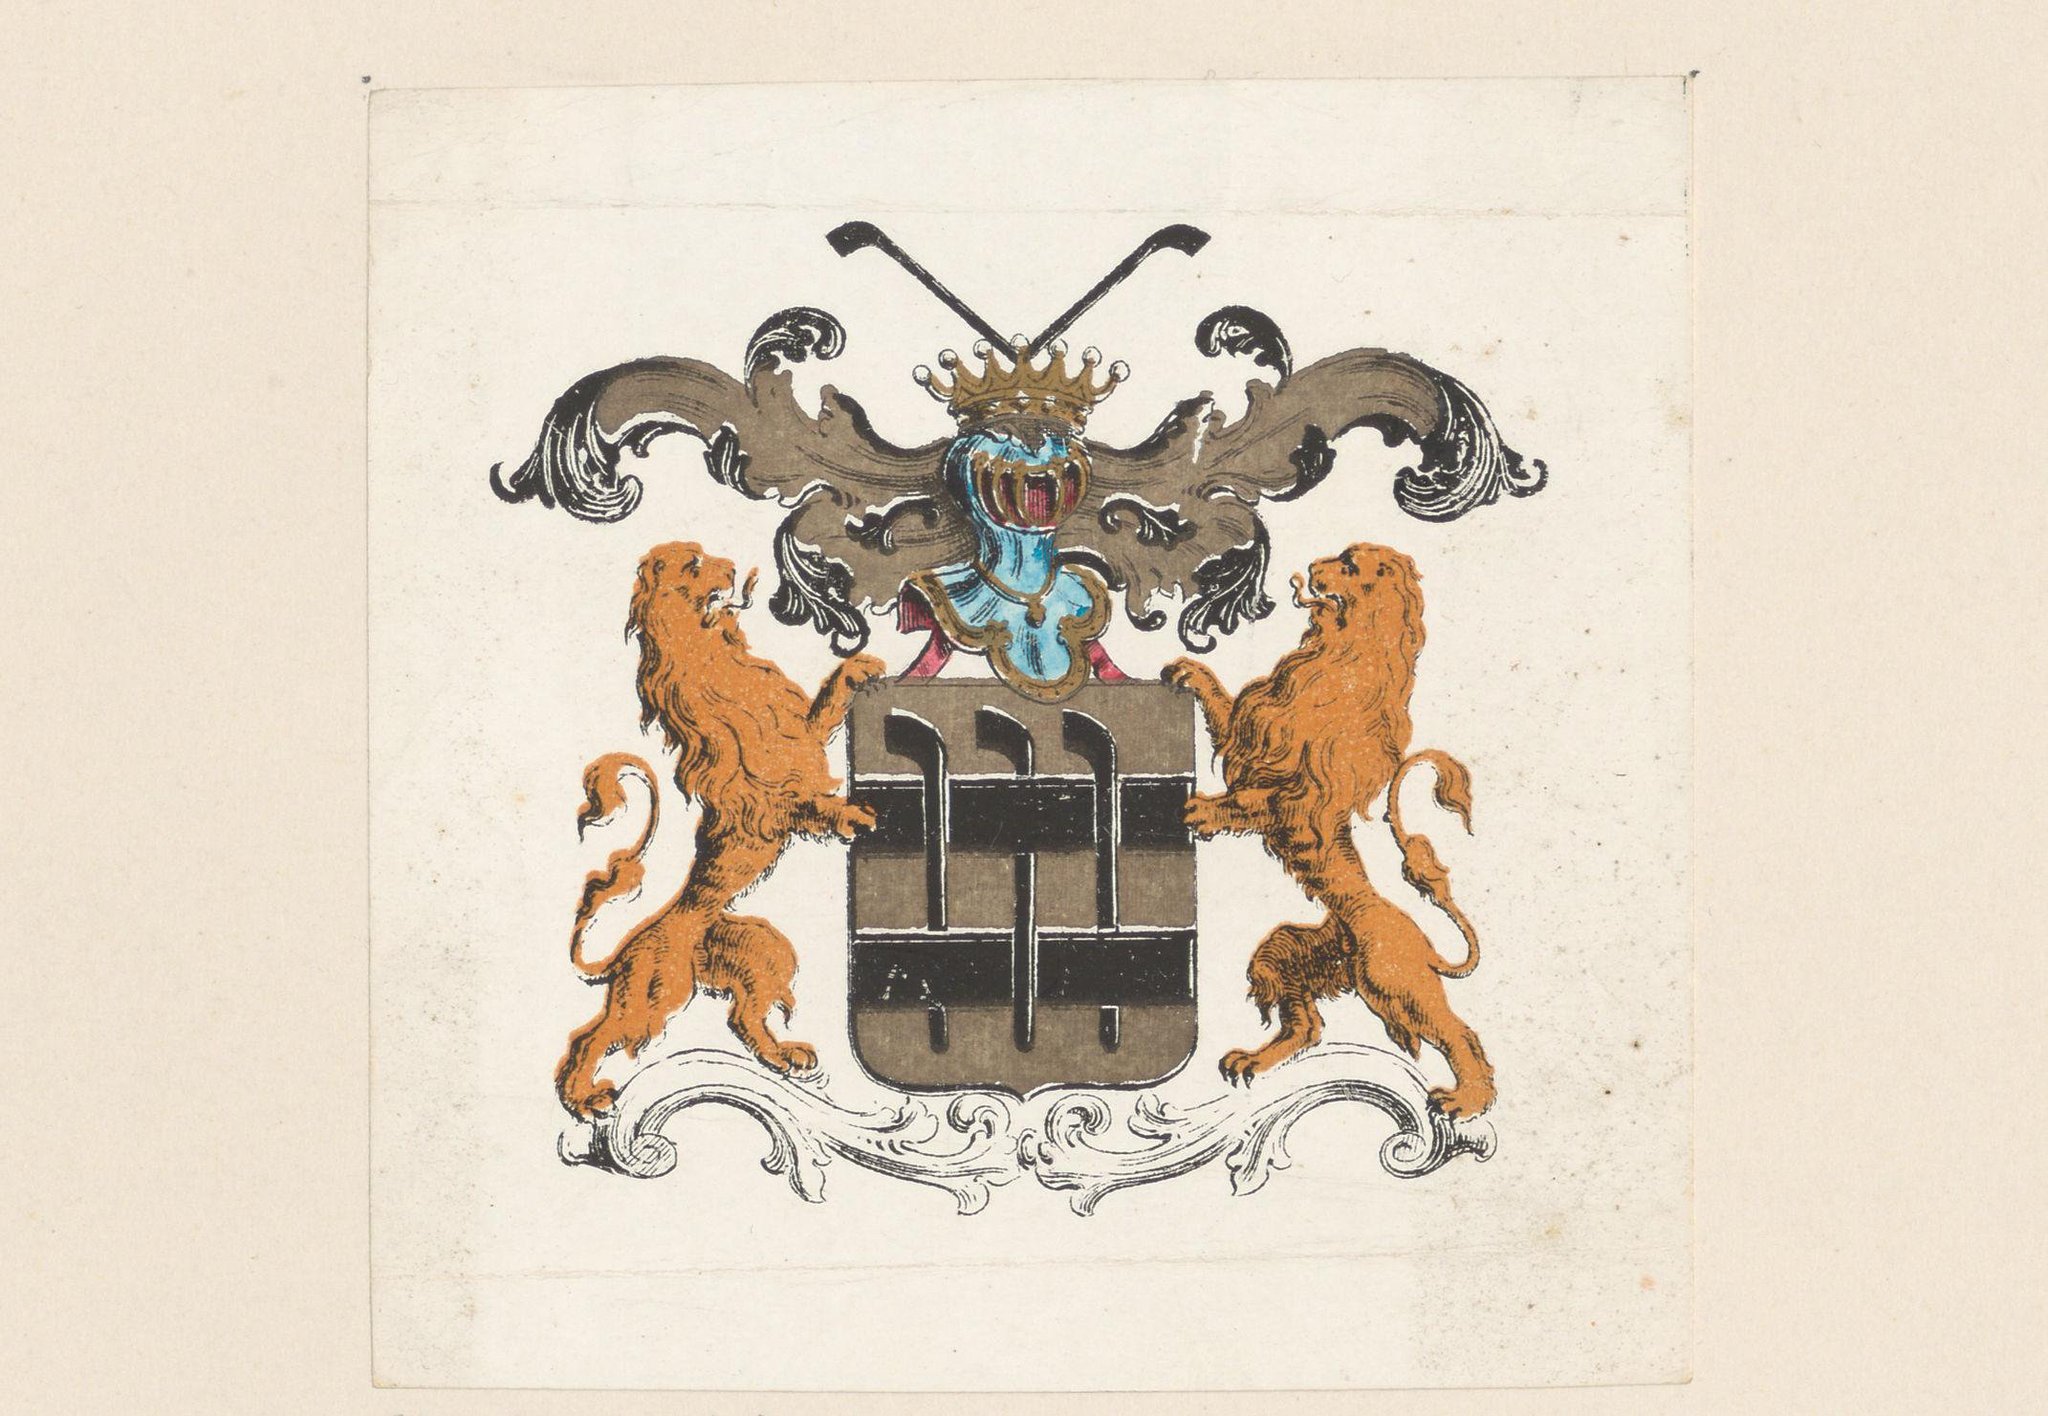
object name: bookplate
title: Ex libris van onbekend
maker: Anonymous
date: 1850-1924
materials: paper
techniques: hand coloring, printing block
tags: beasts of prey, predatory animals: lion, armorial bearing, heraldry